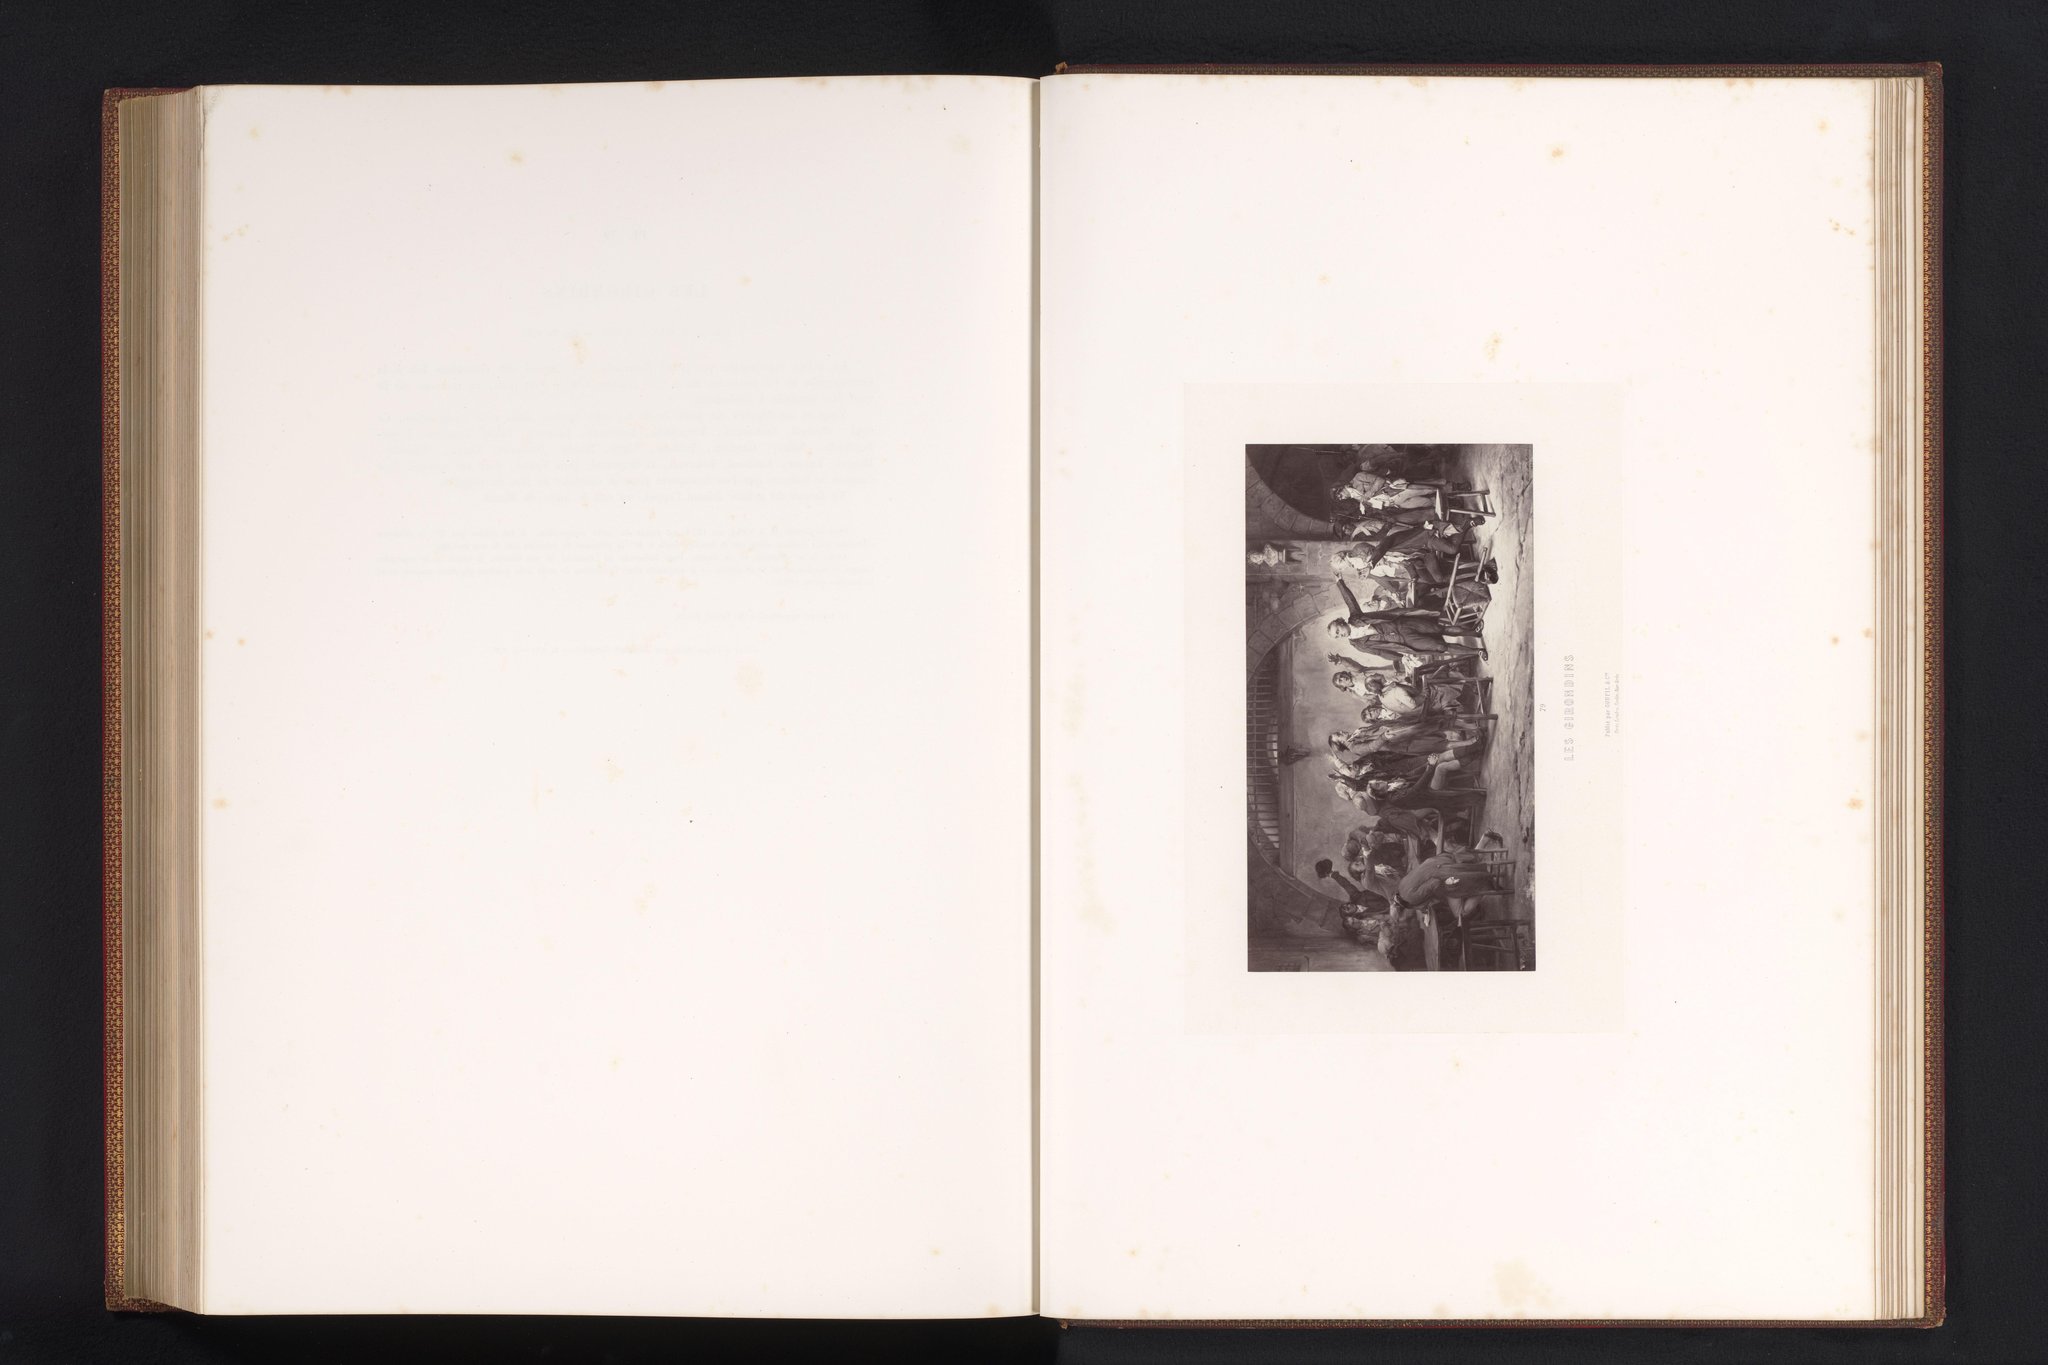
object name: page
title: Les Girondins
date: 1856-1858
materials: paper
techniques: albumen print, engraving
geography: paris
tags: revolutionary committee, rebel group, political parties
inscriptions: check stamp: ‘Goupil & Cie’